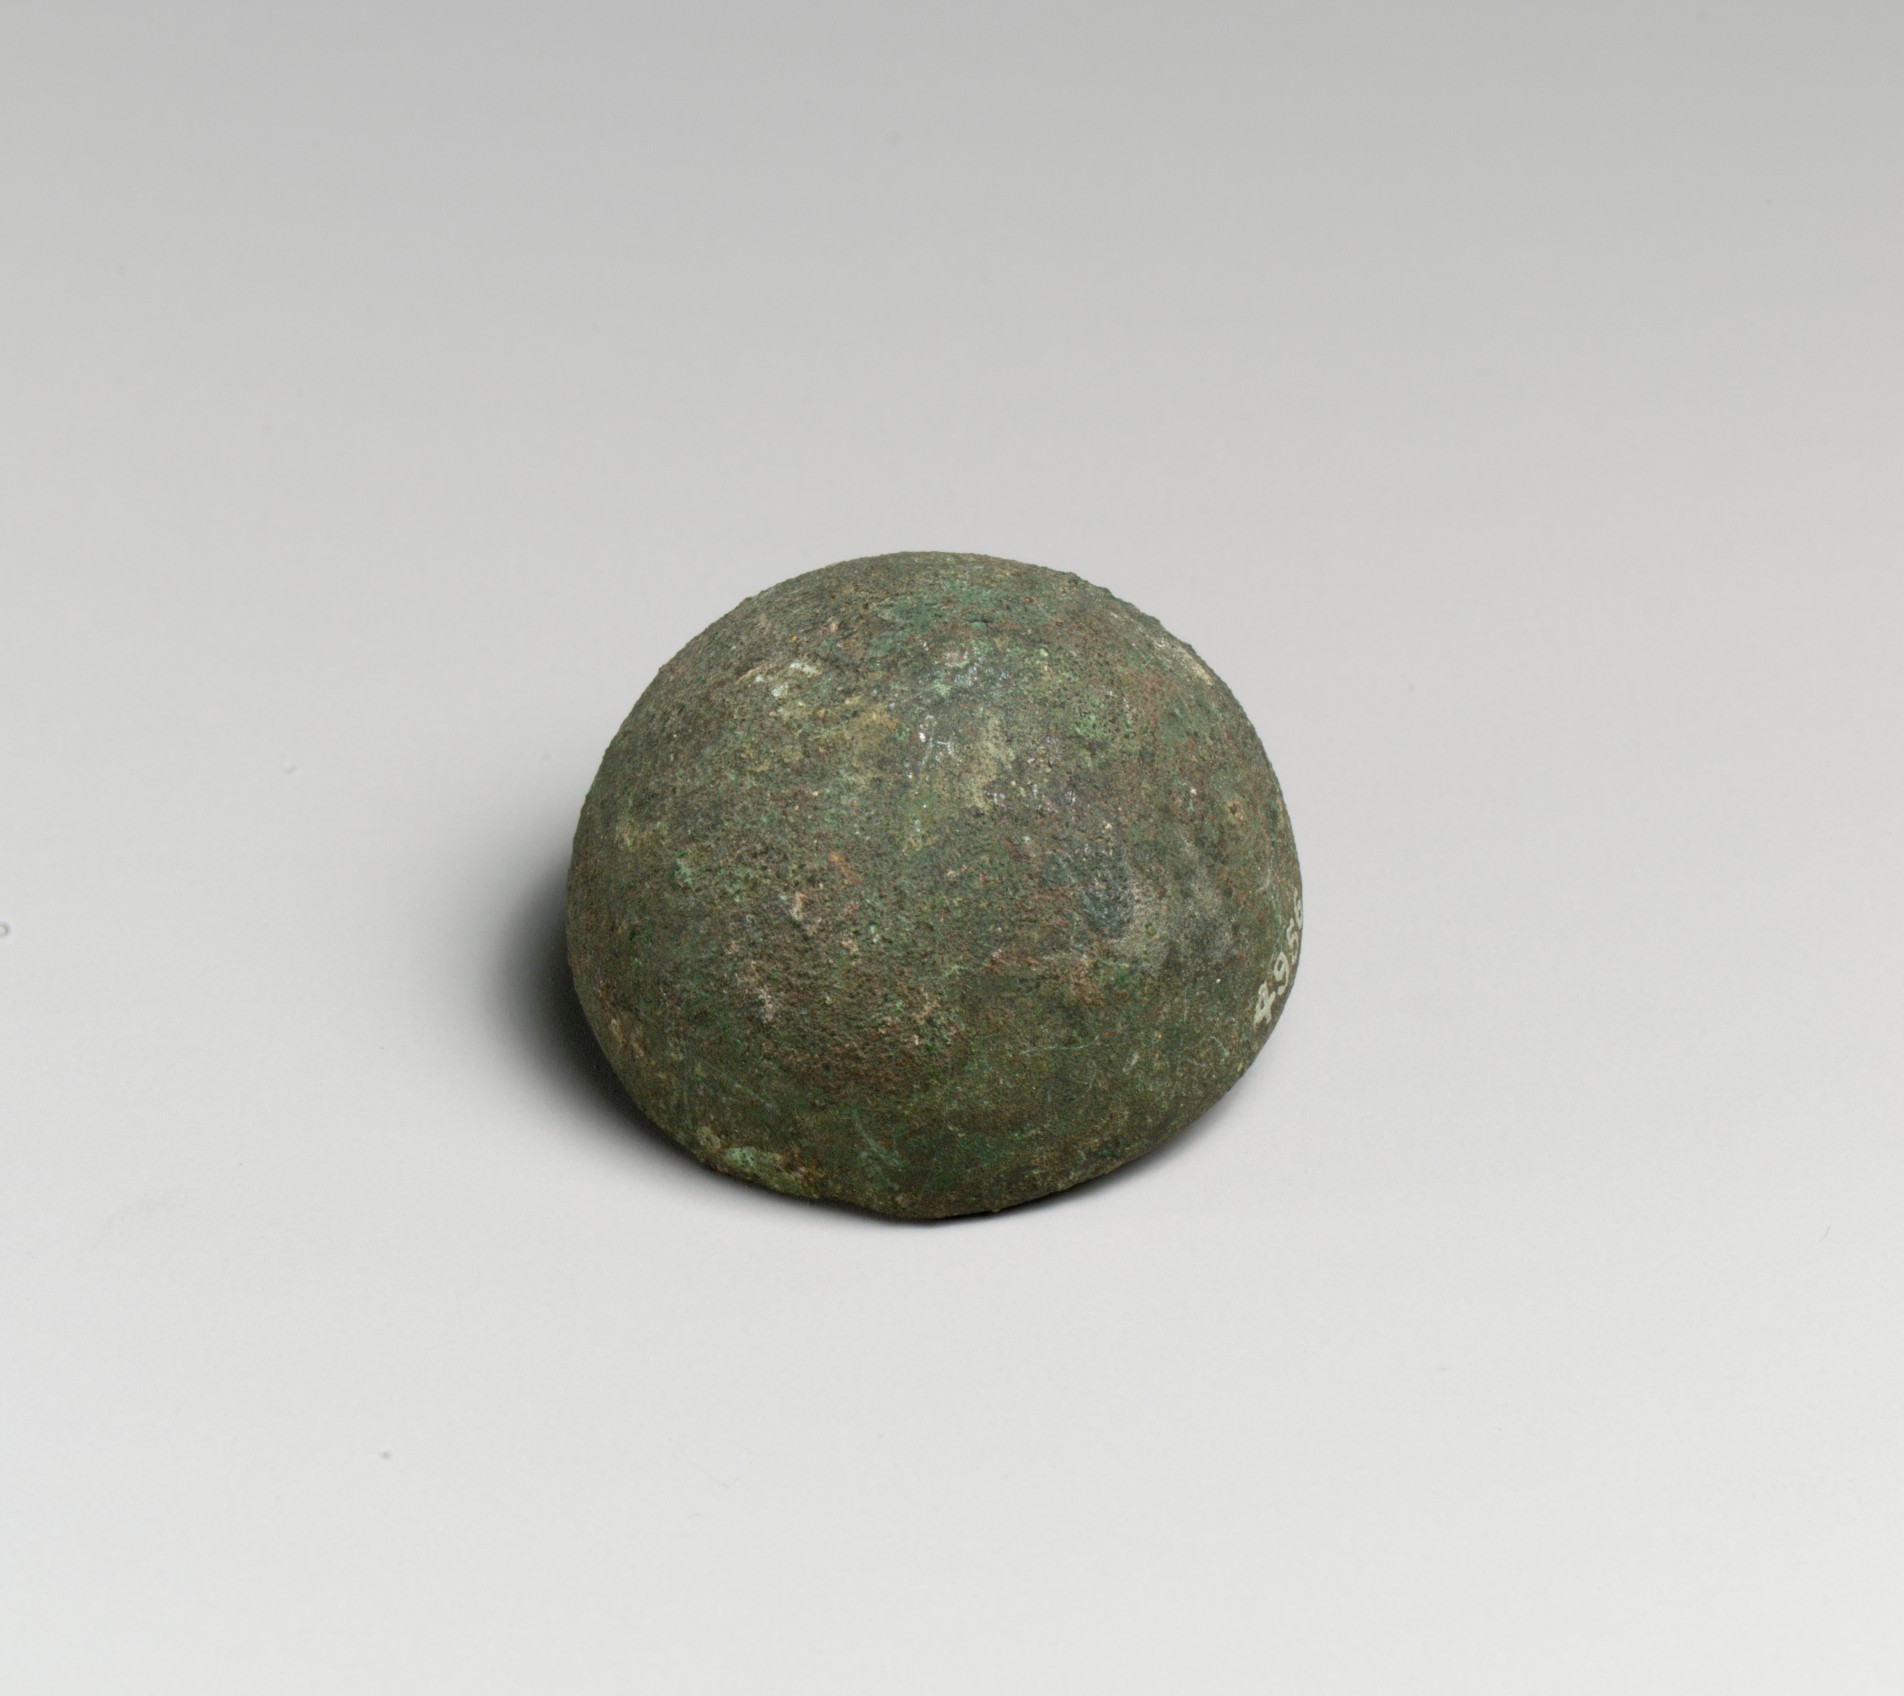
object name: shield bos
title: Shield boss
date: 7000 BCE-330 CE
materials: bronze